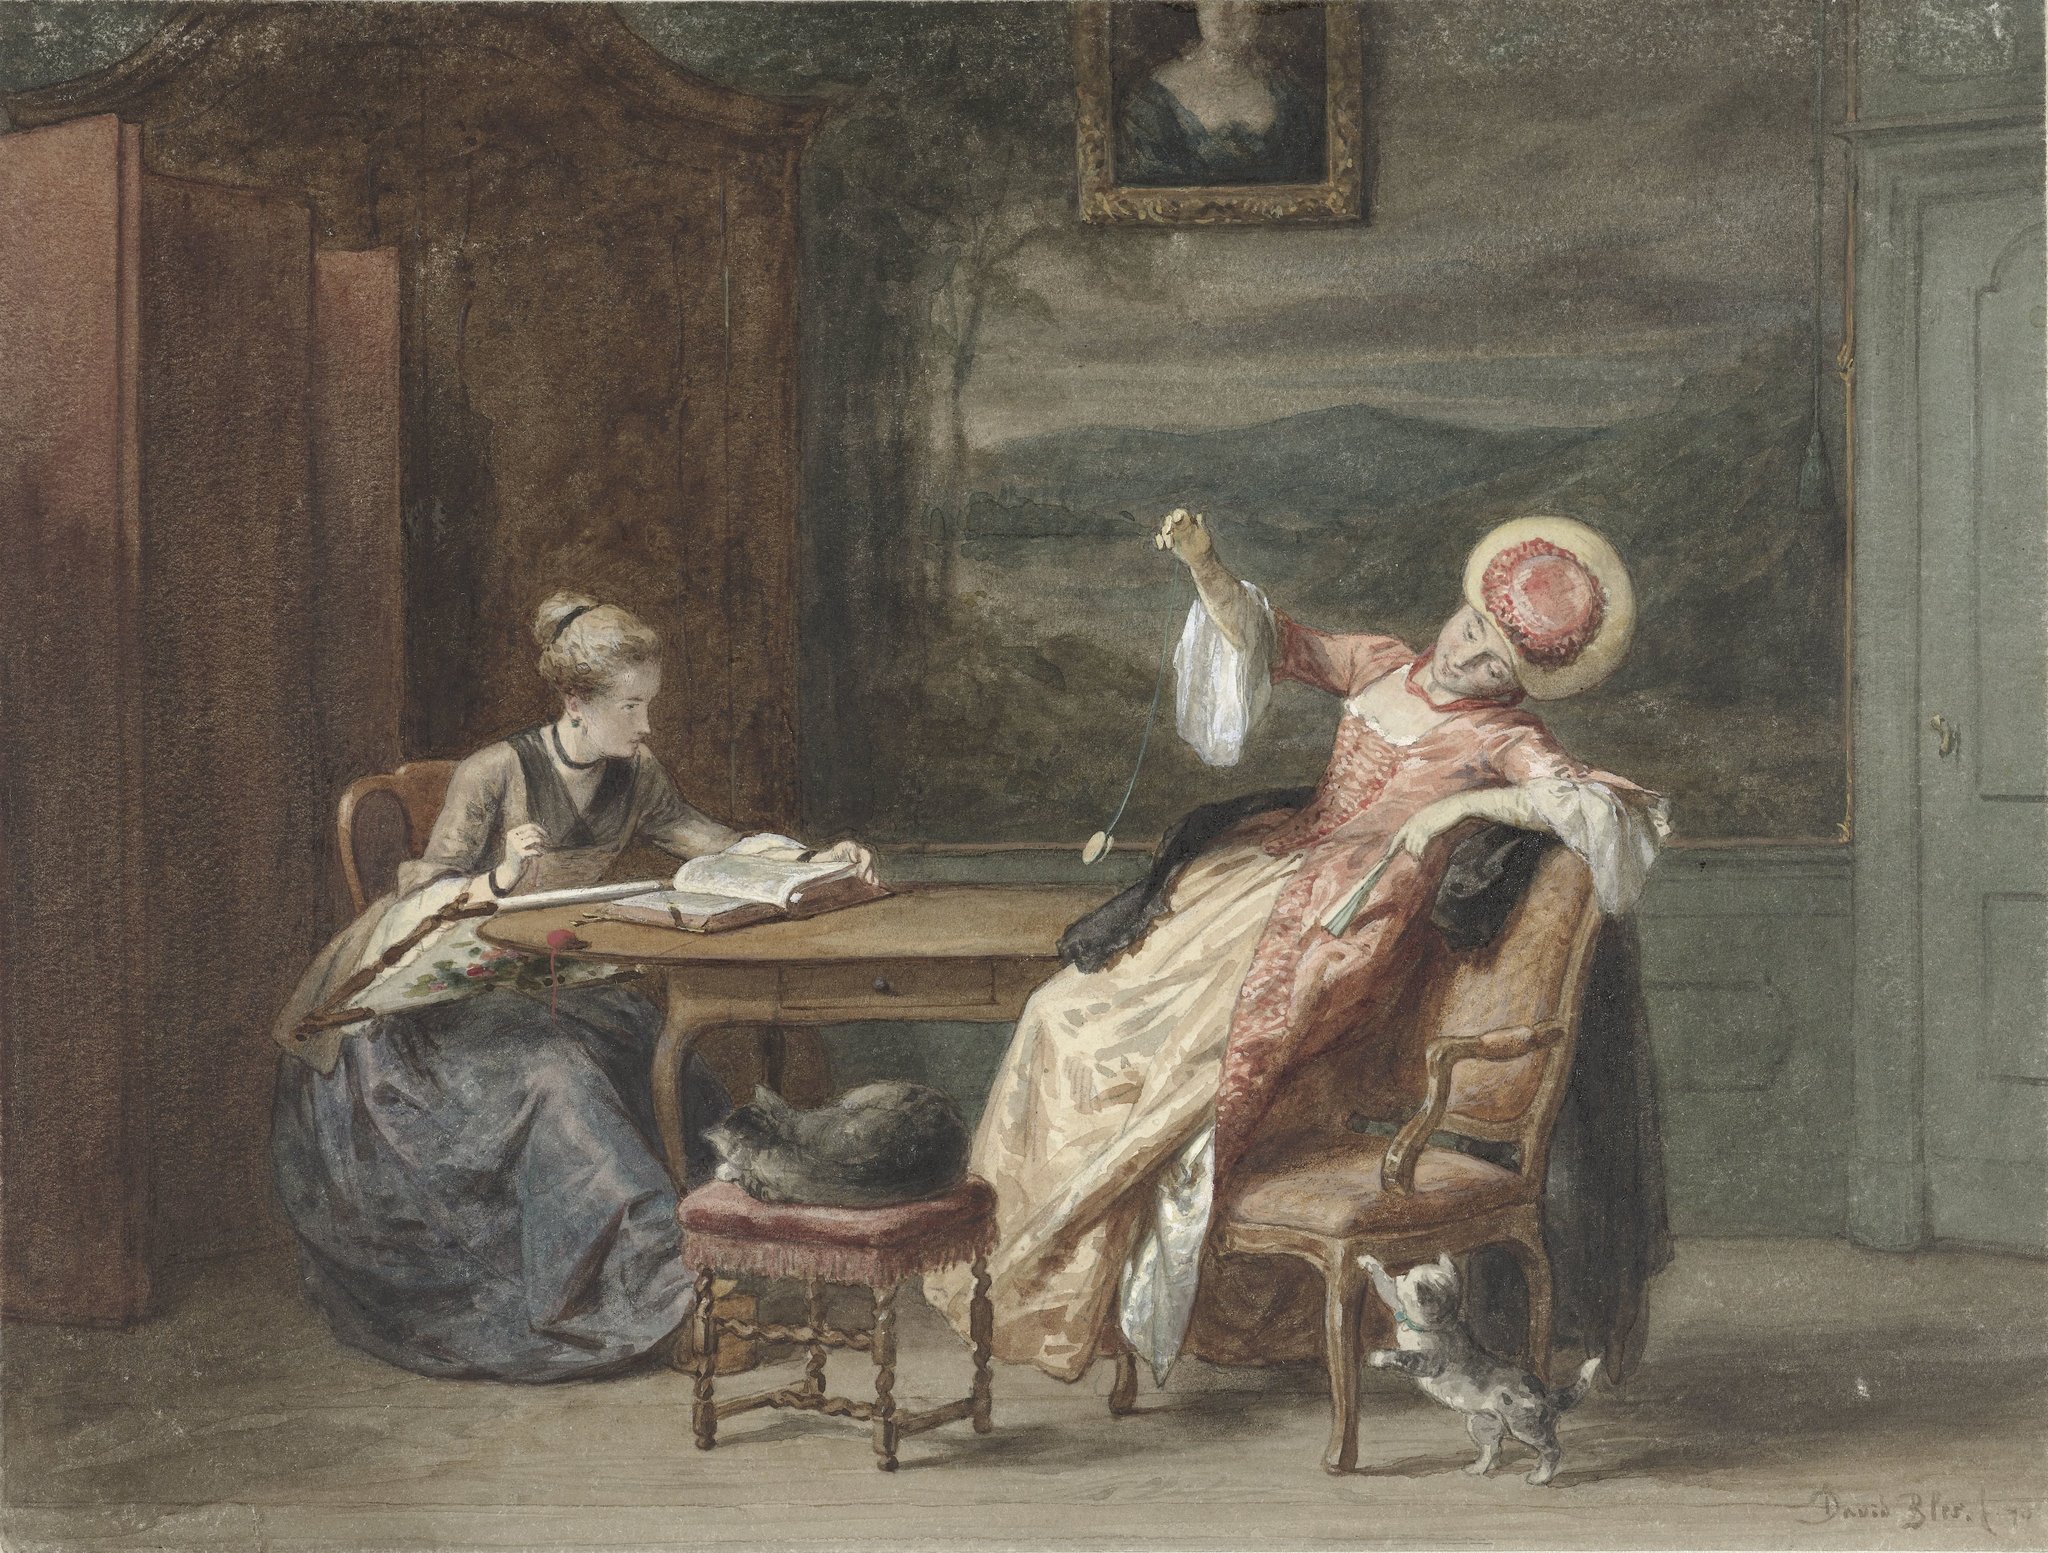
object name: watercolor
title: Twee jonge vrouwen aan een tafel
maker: david bles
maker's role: draughtsman, painter, print maker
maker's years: 1821-1899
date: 1870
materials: paint, paper, pencil, watercolor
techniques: brush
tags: reading, cat, (other forms of) needlework, e.g.: crocheting, knitting, embroidering, yoyo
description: Twee jonge vrouwen aan een tafel; één borduurt en leest de Bijbel terwijl de ander met een jojo en een poes speelt.